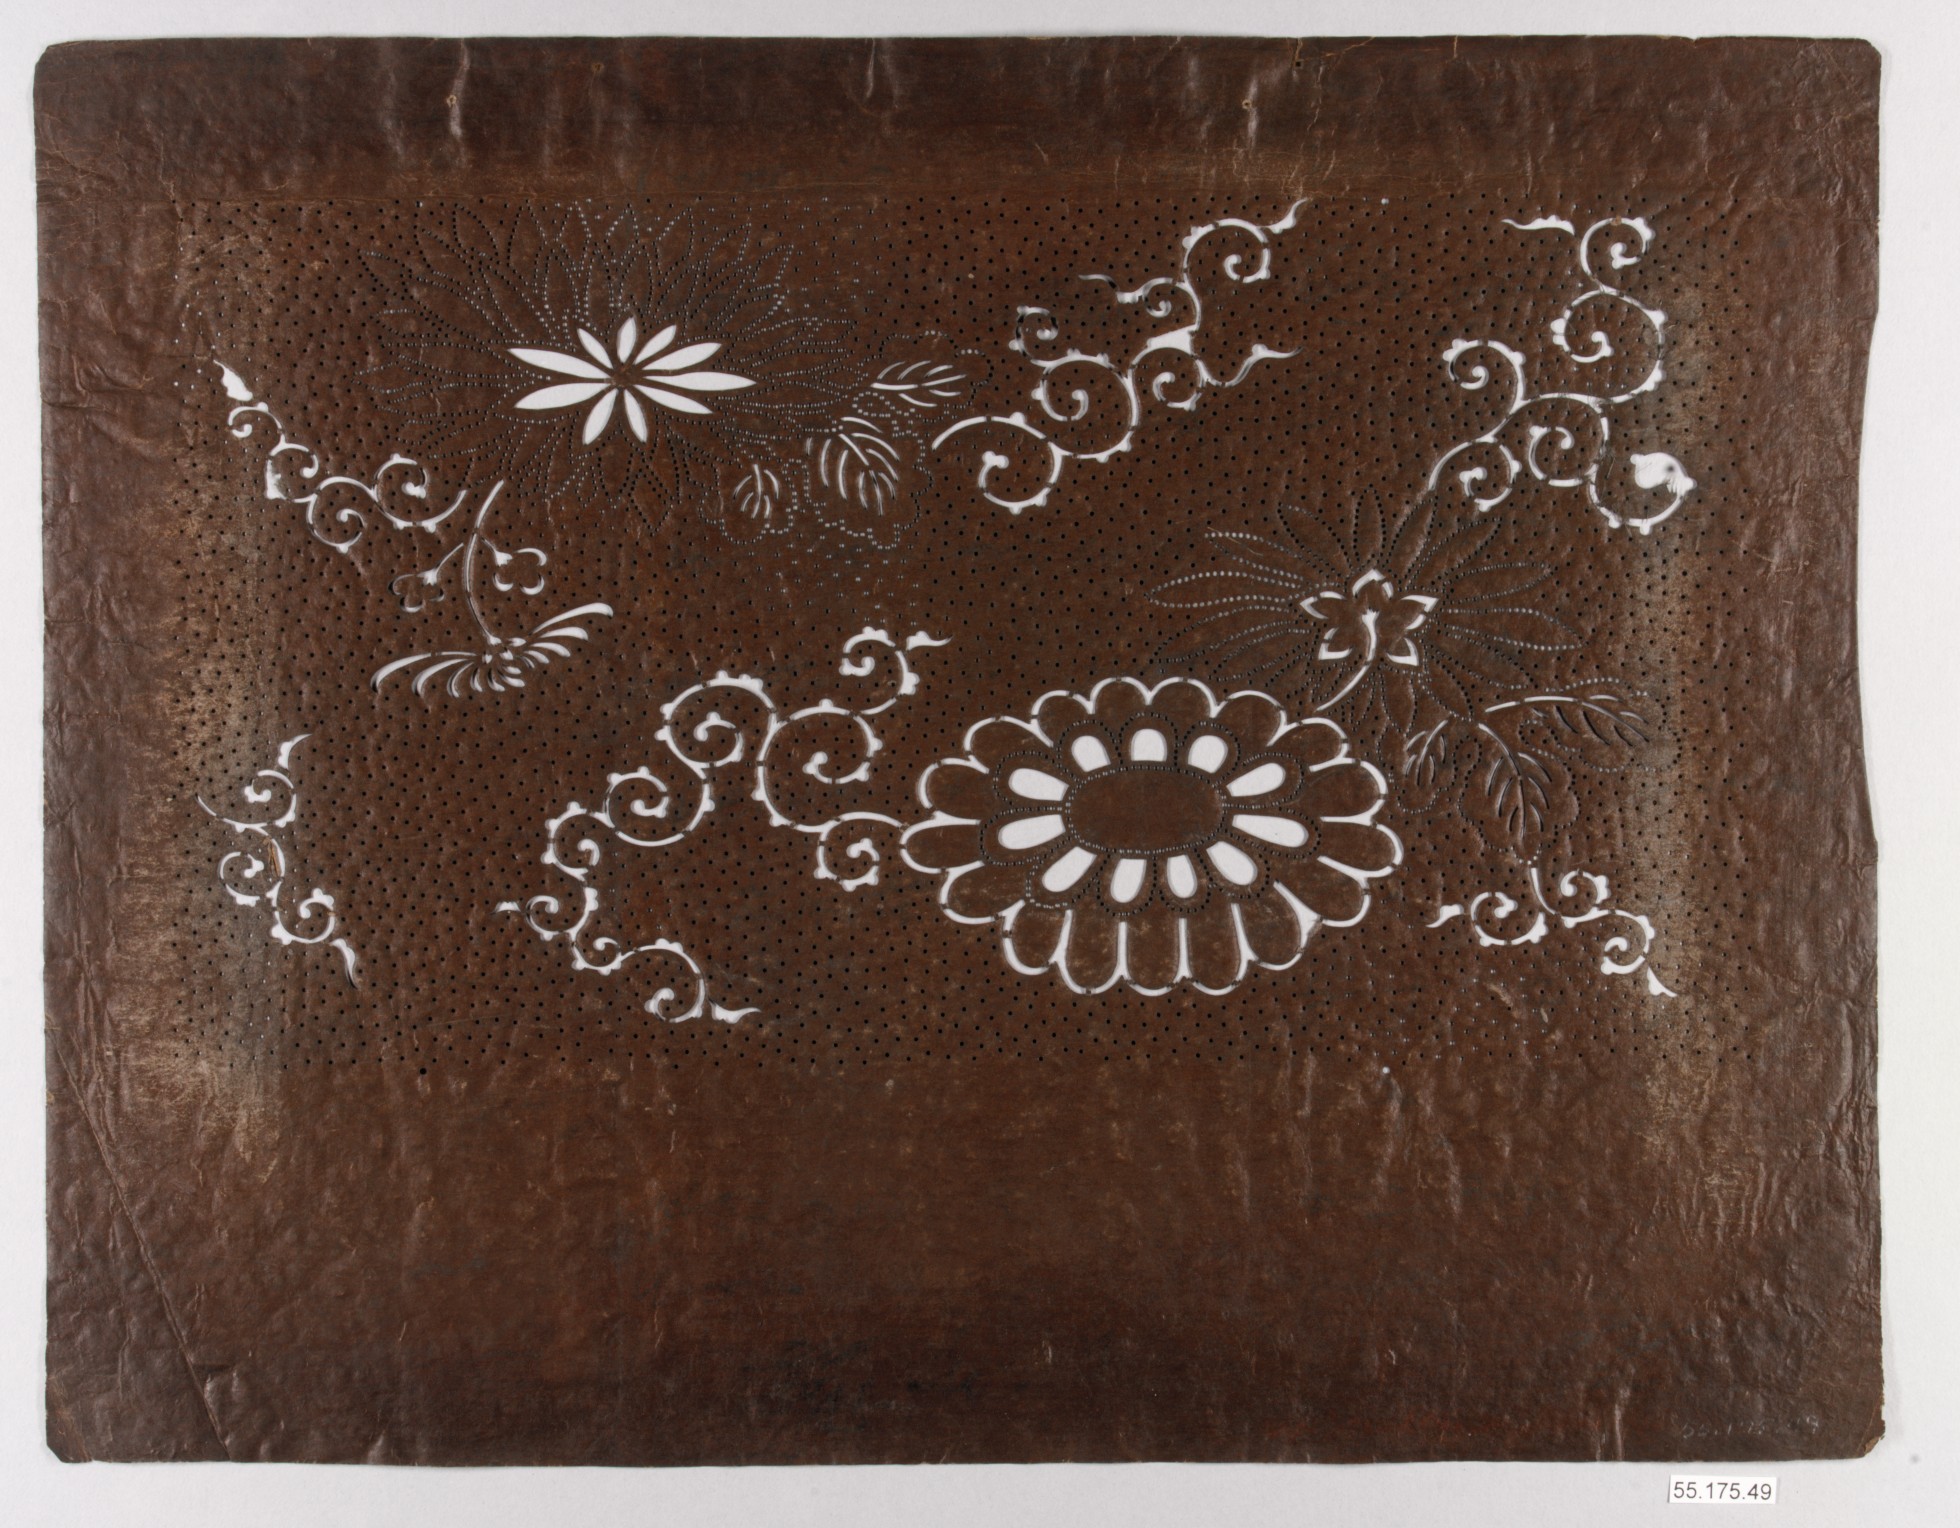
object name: stencil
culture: japanese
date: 1801-1900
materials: paper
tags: flowers